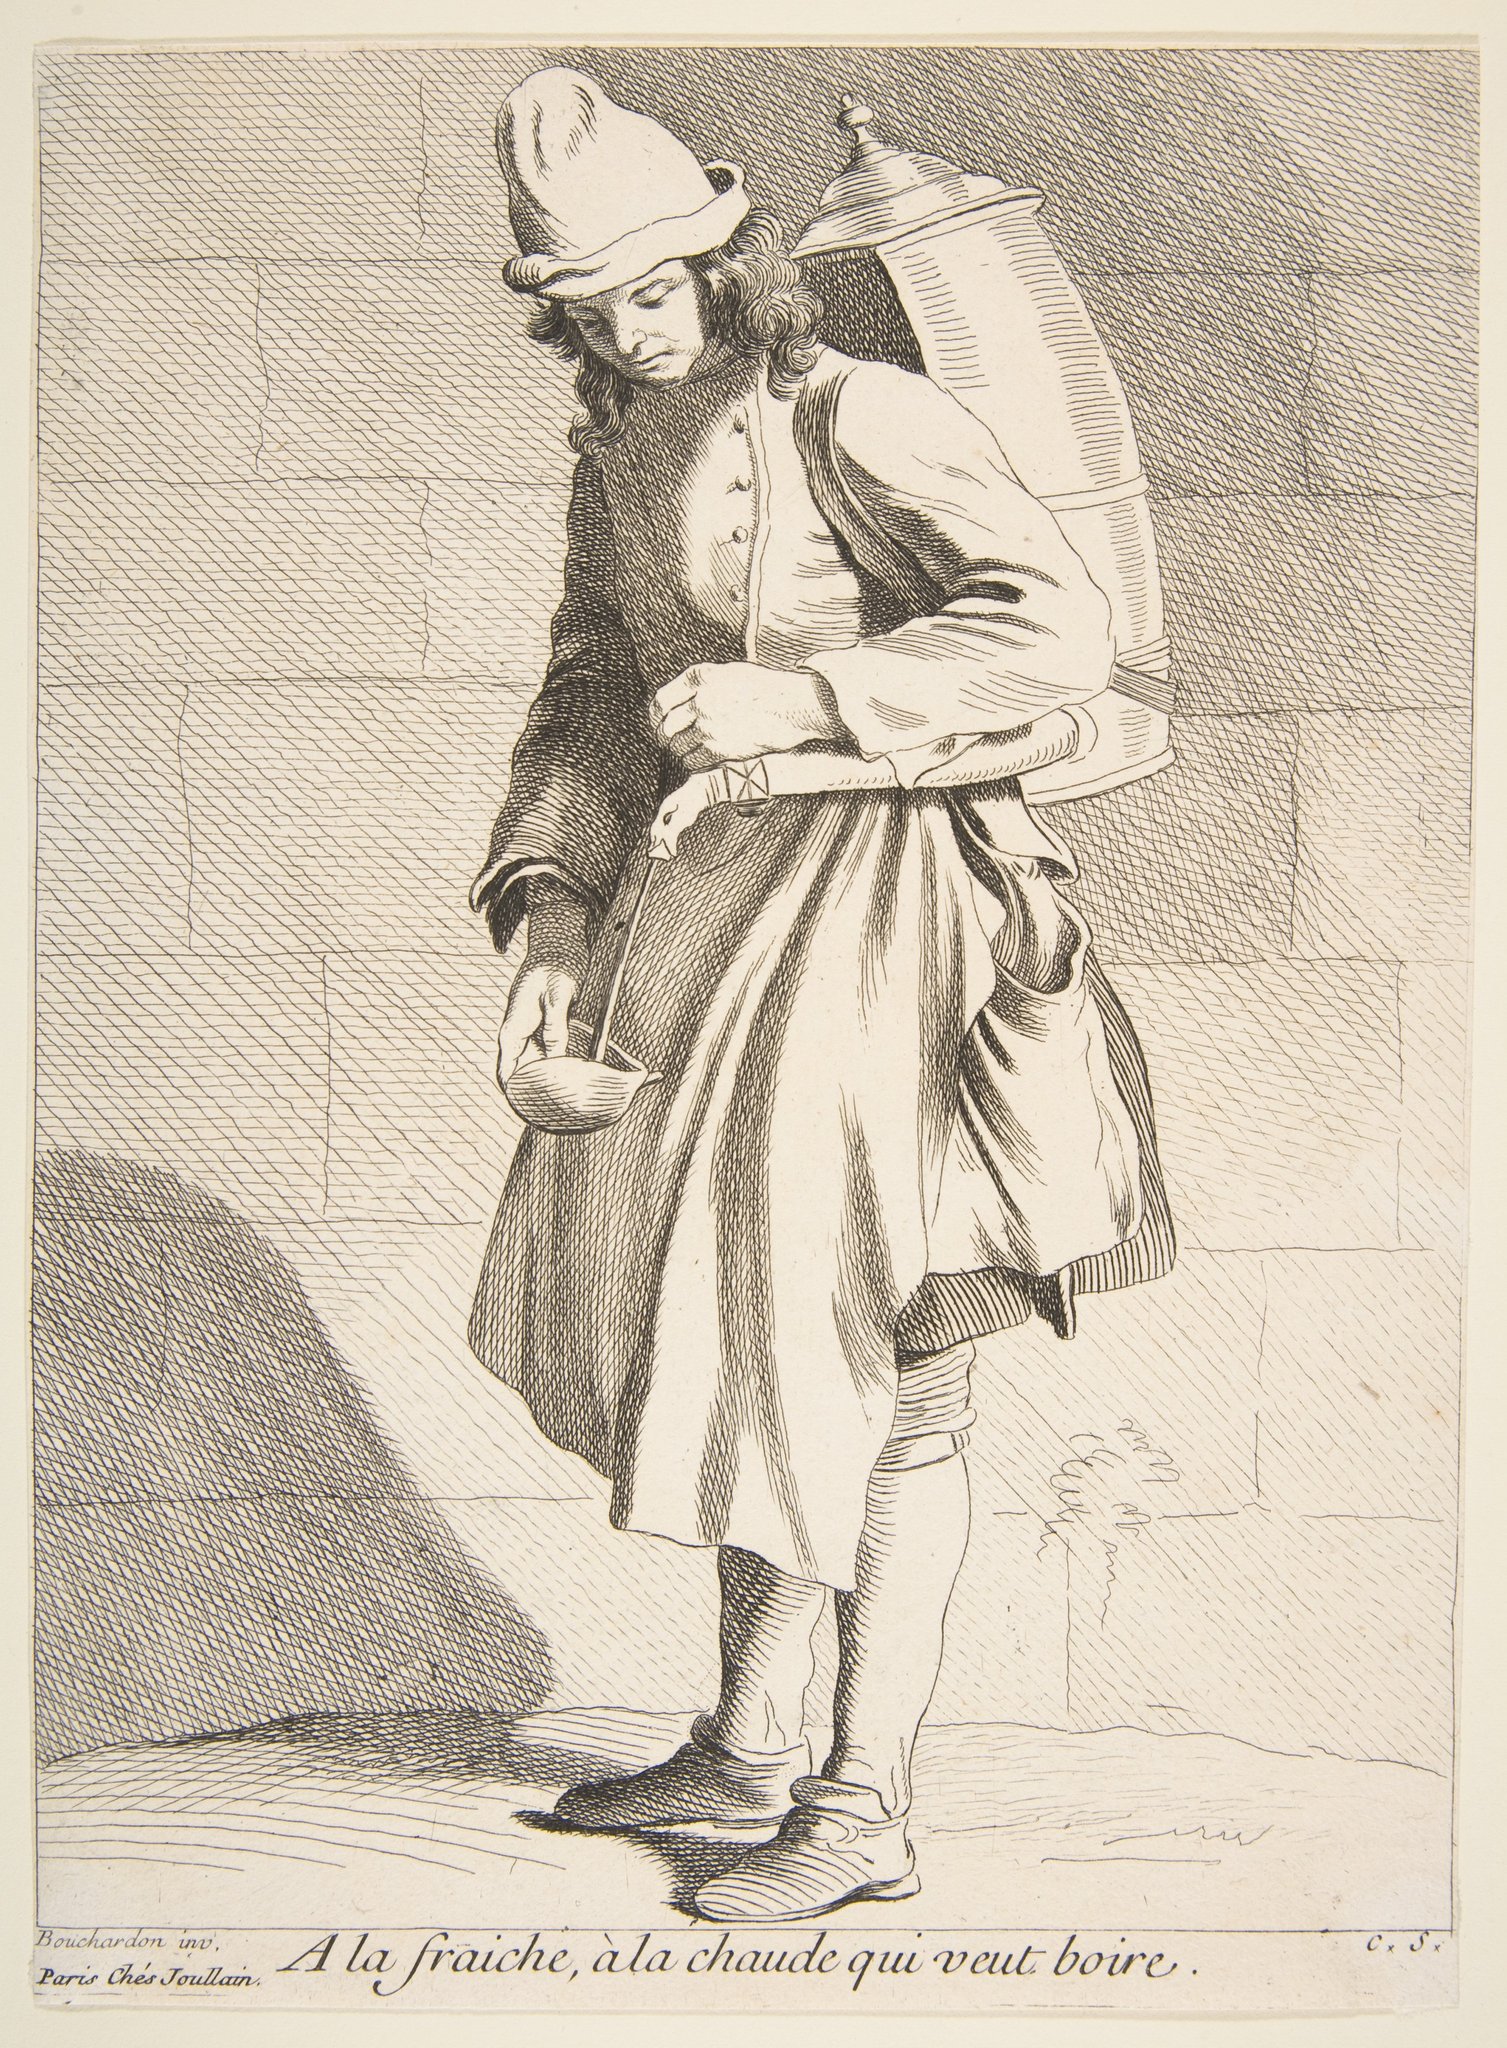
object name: print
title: Drinks Vendor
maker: anne claude philippe de tubières, comte de caylus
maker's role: artist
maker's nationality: french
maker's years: 1692-1765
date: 1737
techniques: engraving, etching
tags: men